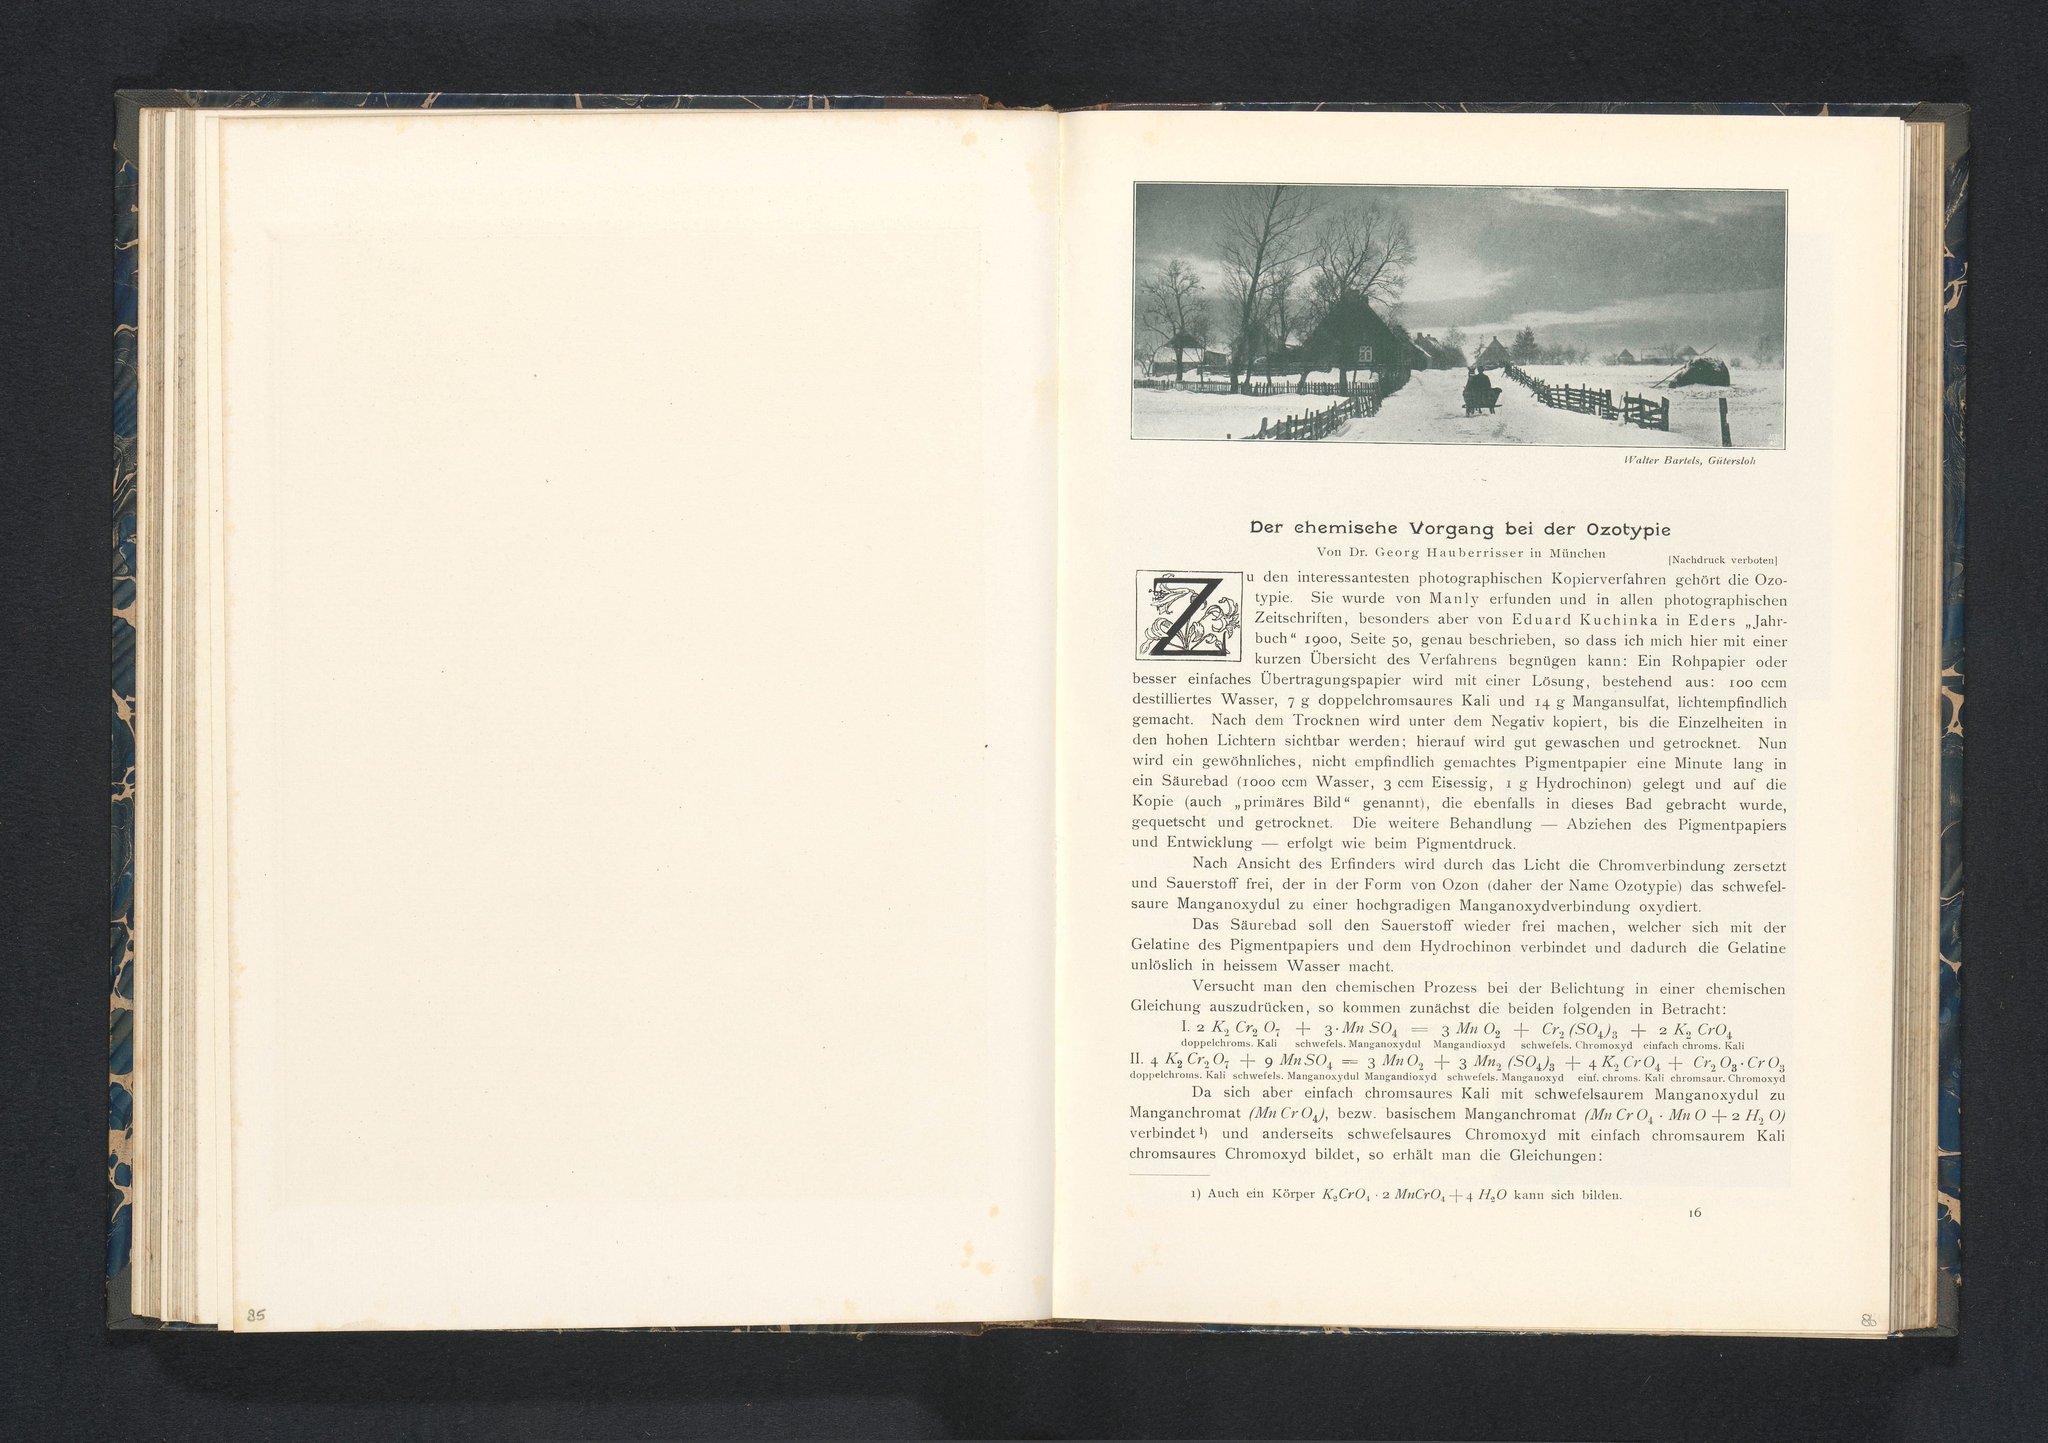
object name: page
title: Winters landschap met een huis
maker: walter bartels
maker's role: fotograaf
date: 1896-1901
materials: paper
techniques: autotype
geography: berlin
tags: landscapes, rural housing, e.g. country-house, villa, cottage